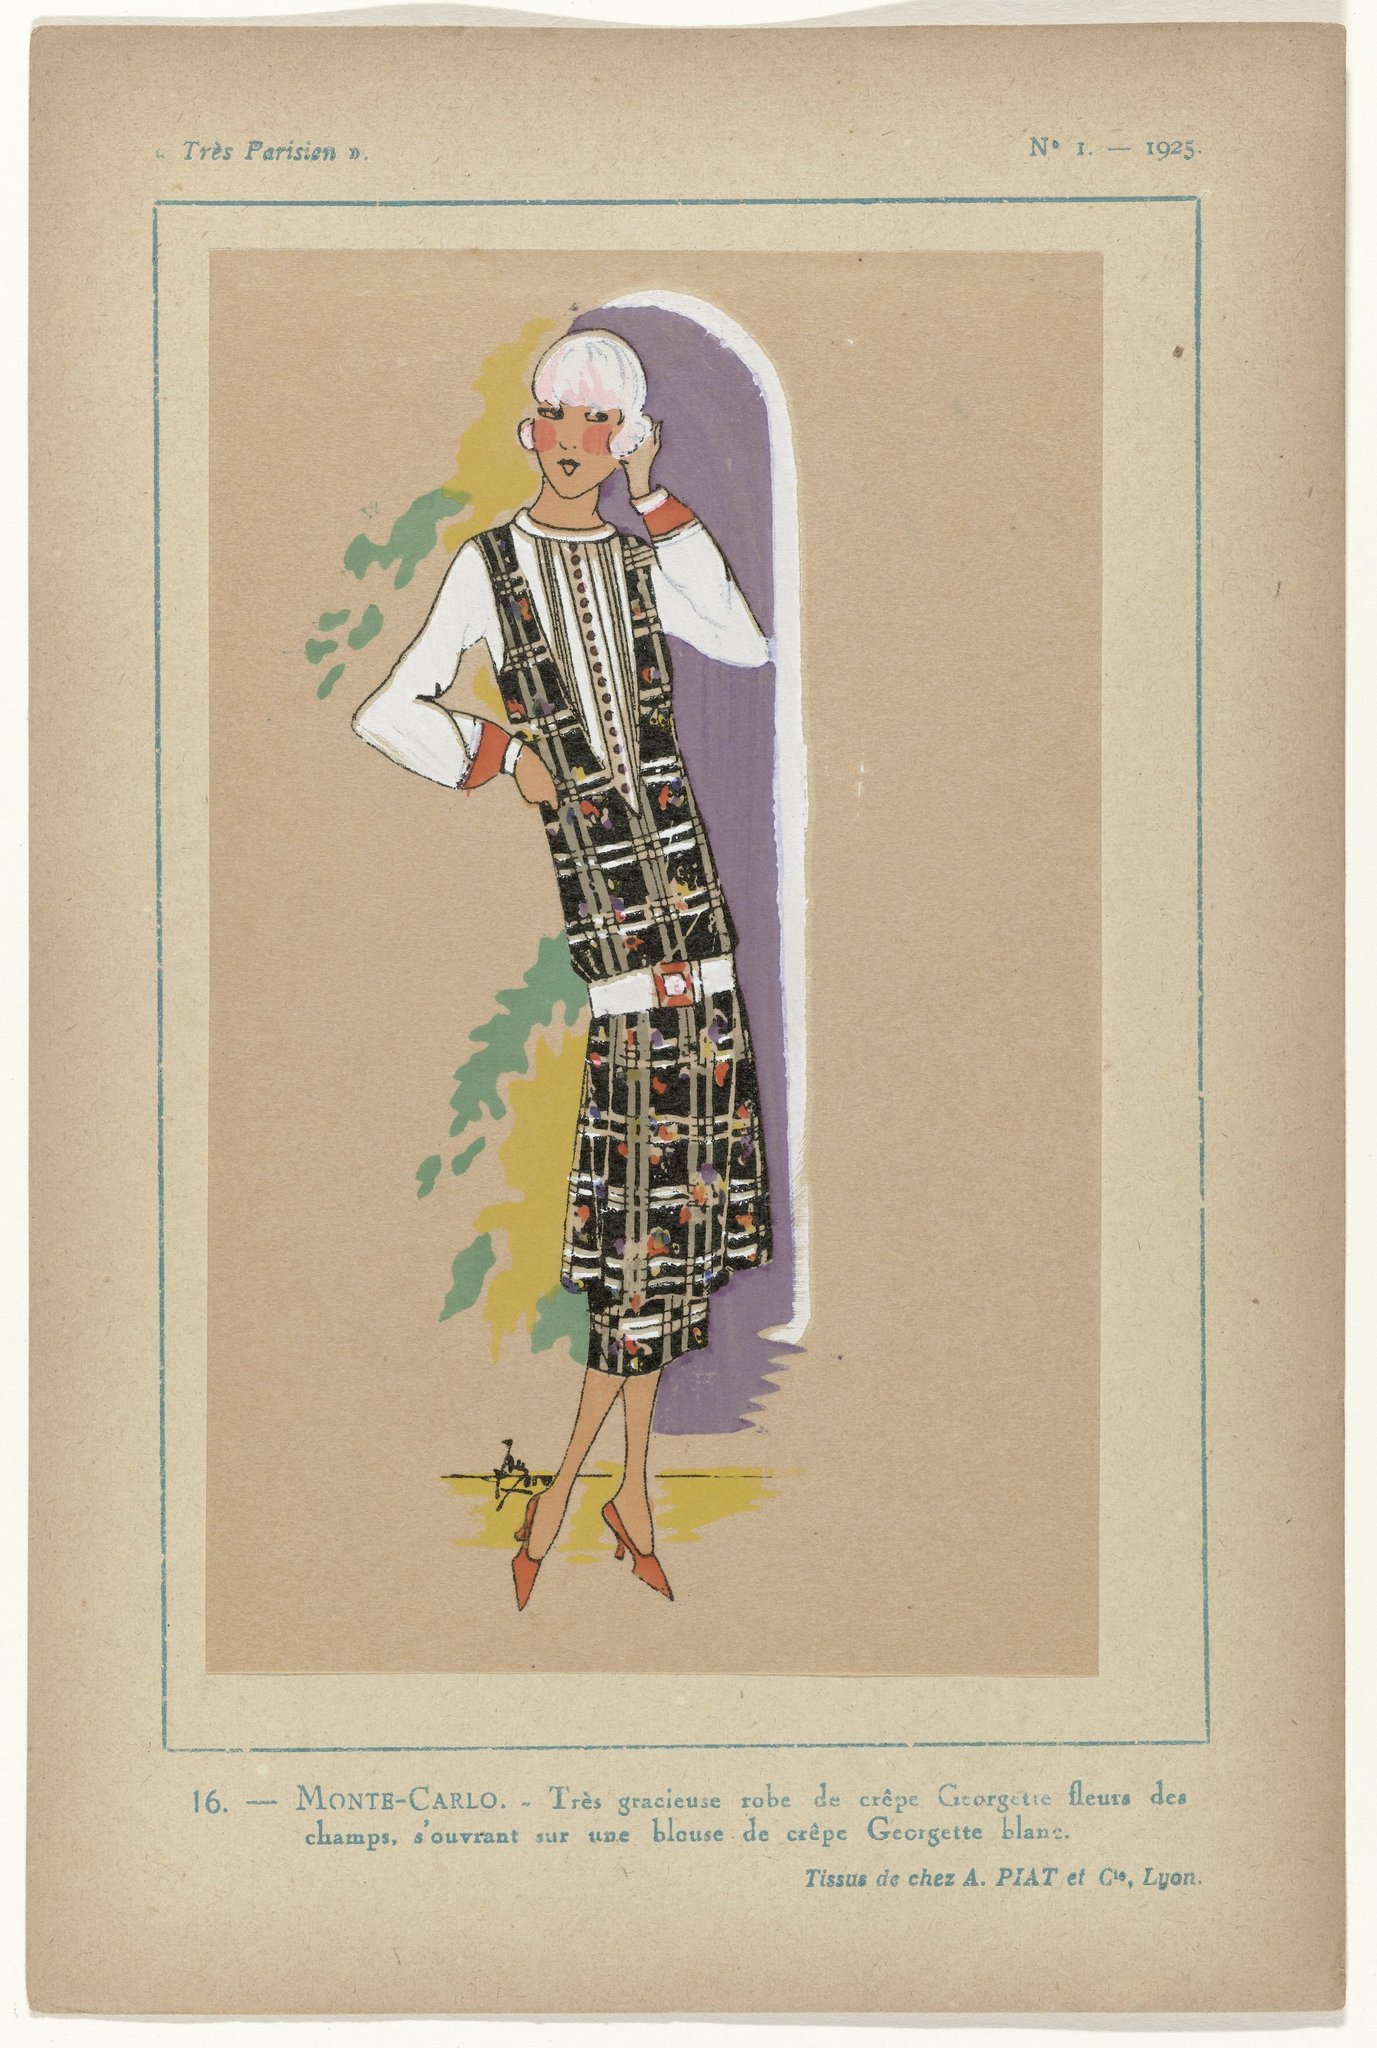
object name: fashion print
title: Très Parisien, 1925, No. 1, Pl. 16.- MONTE CARLO.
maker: g-p. joumard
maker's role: publisher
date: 1925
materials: paper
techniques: hand coloring, letterpress printing, lithography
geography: paris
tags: clothing for the upper part of the body: blouse (+ women's clothes), dress, gown: day dress (+ women's clothes), fashion plates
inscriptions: caption: ‘MONTE CARLO. - Très gracieuse robe de crêpe Georgette fleurs des champs, s'ouvrant sur une blouse de crêpe Georgette blanc. Tissus de chez A. PIAT et Cie, Lon.’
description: Japon van gebloemde crêpe Georgette met blouse van witte crêpe Georgette. Stof van A. Piat, Lyon. Prent uit het modetijdschrift Très Parisien...La Mode, Le Chic, L'Élégance (1920-1936)